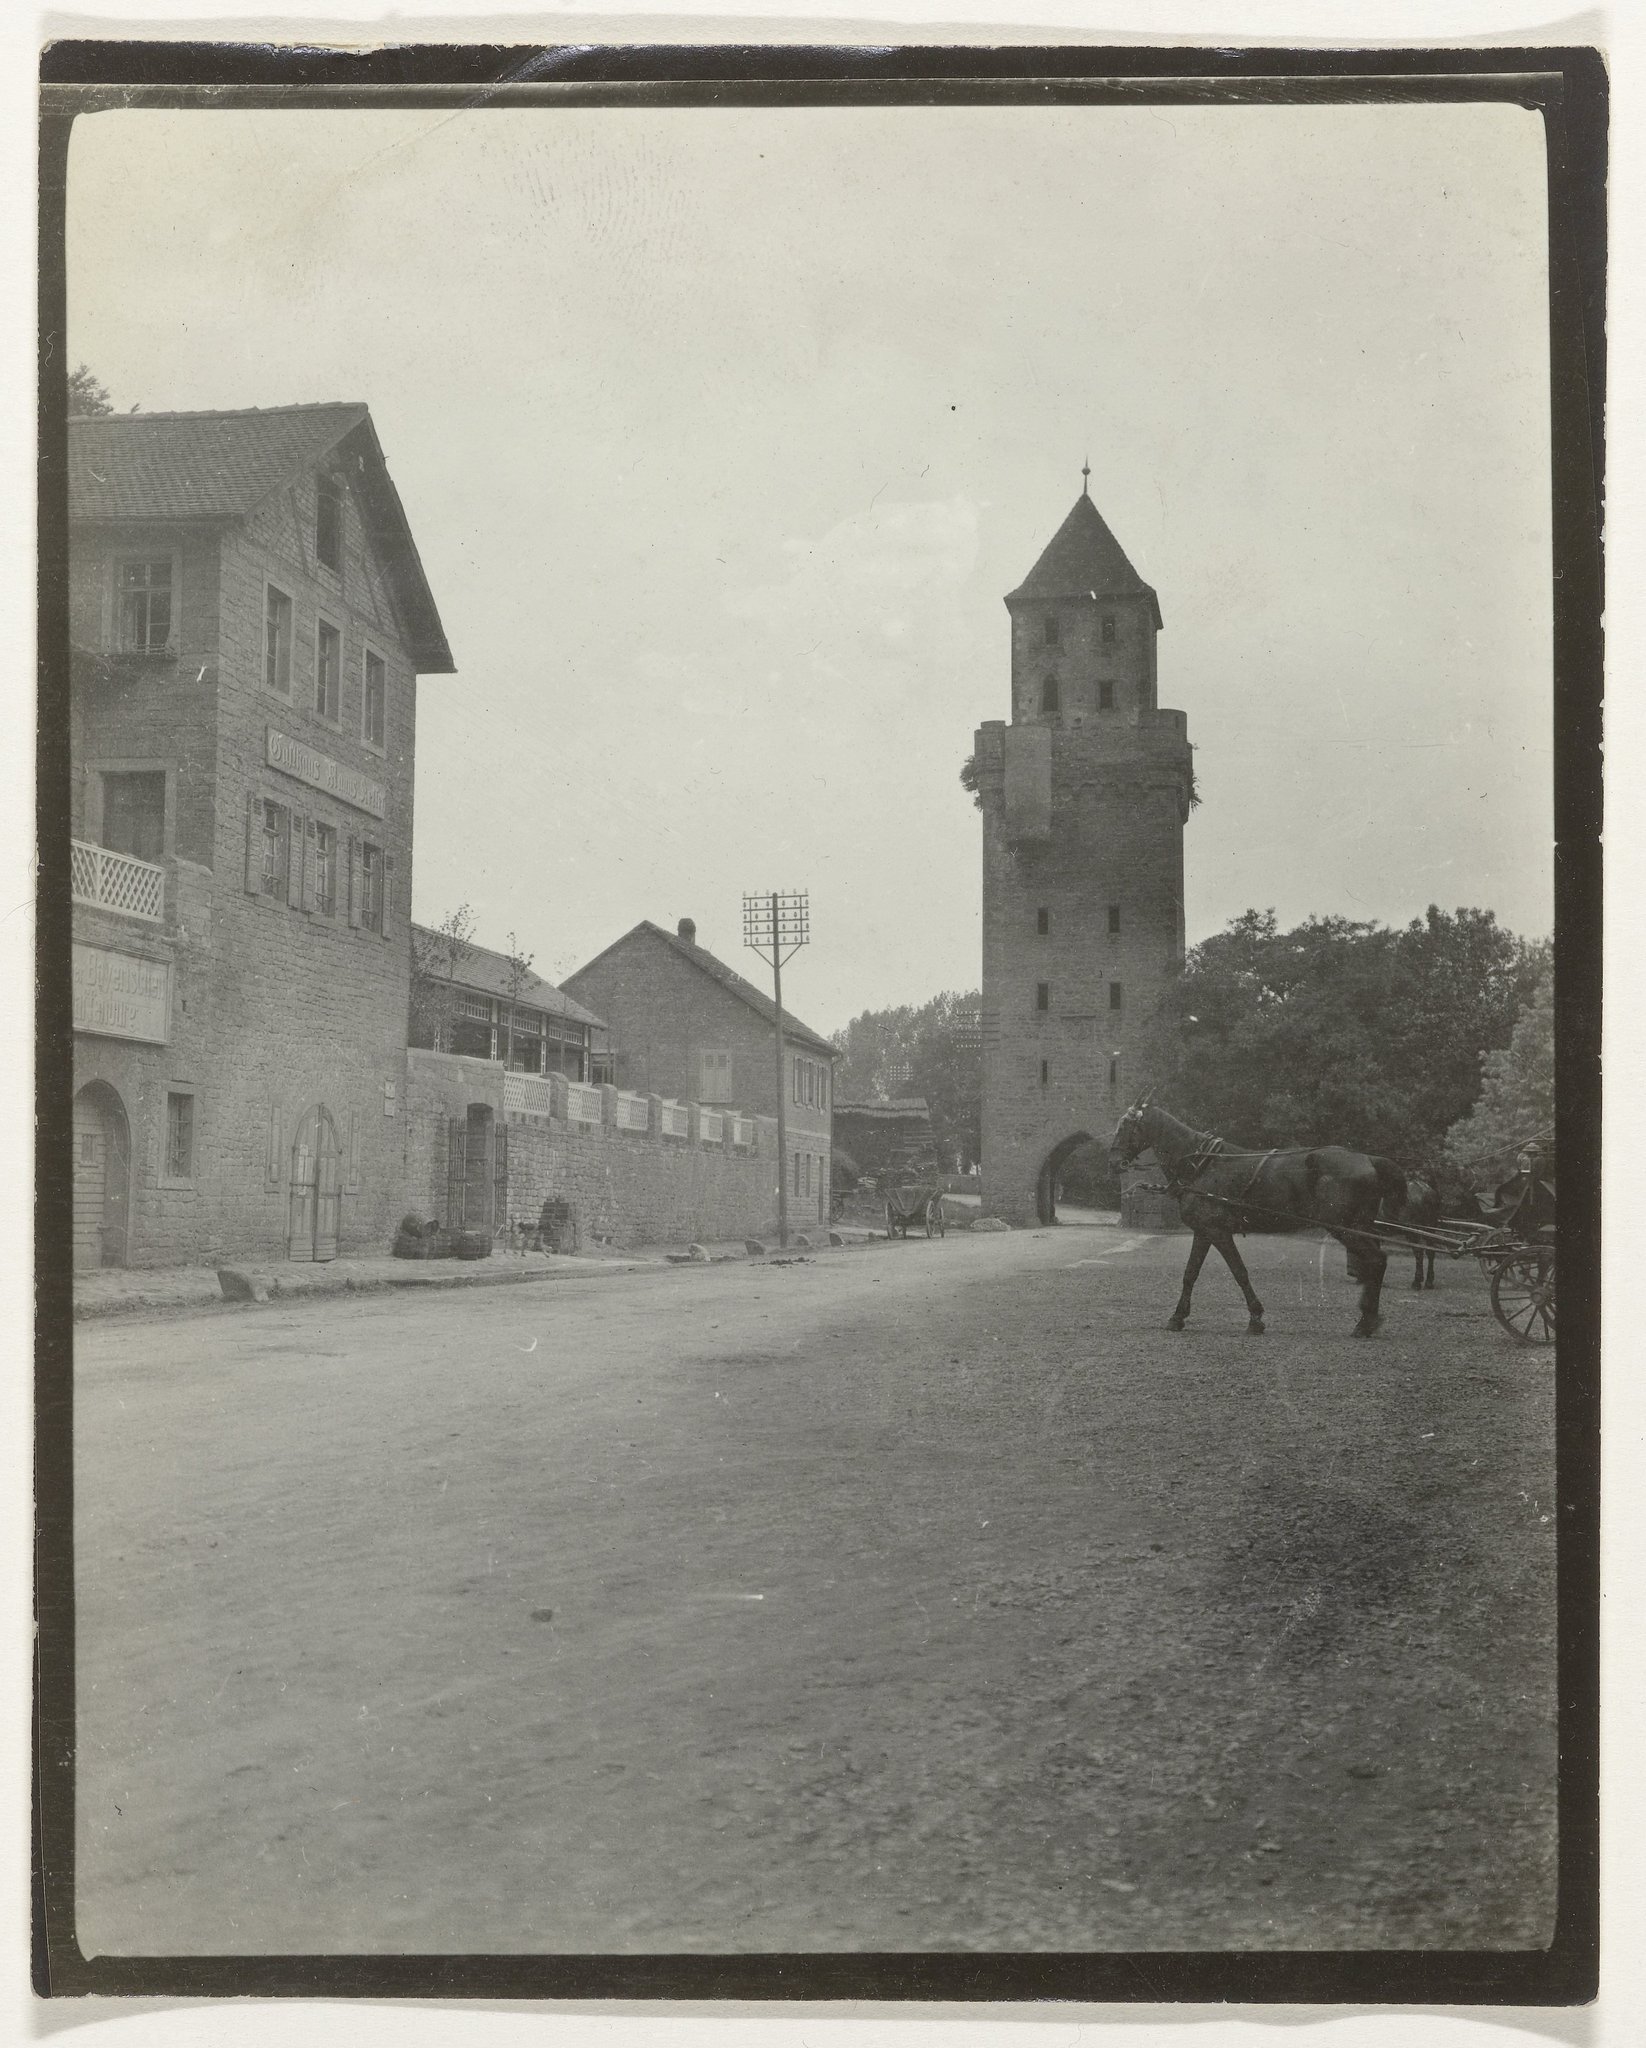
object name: photograph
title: Paard en wagen bij een poort in een stad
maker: Anonymous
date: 1900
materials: paper, photographic support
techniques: gelatin silver print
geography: germany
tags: city-gate, germany